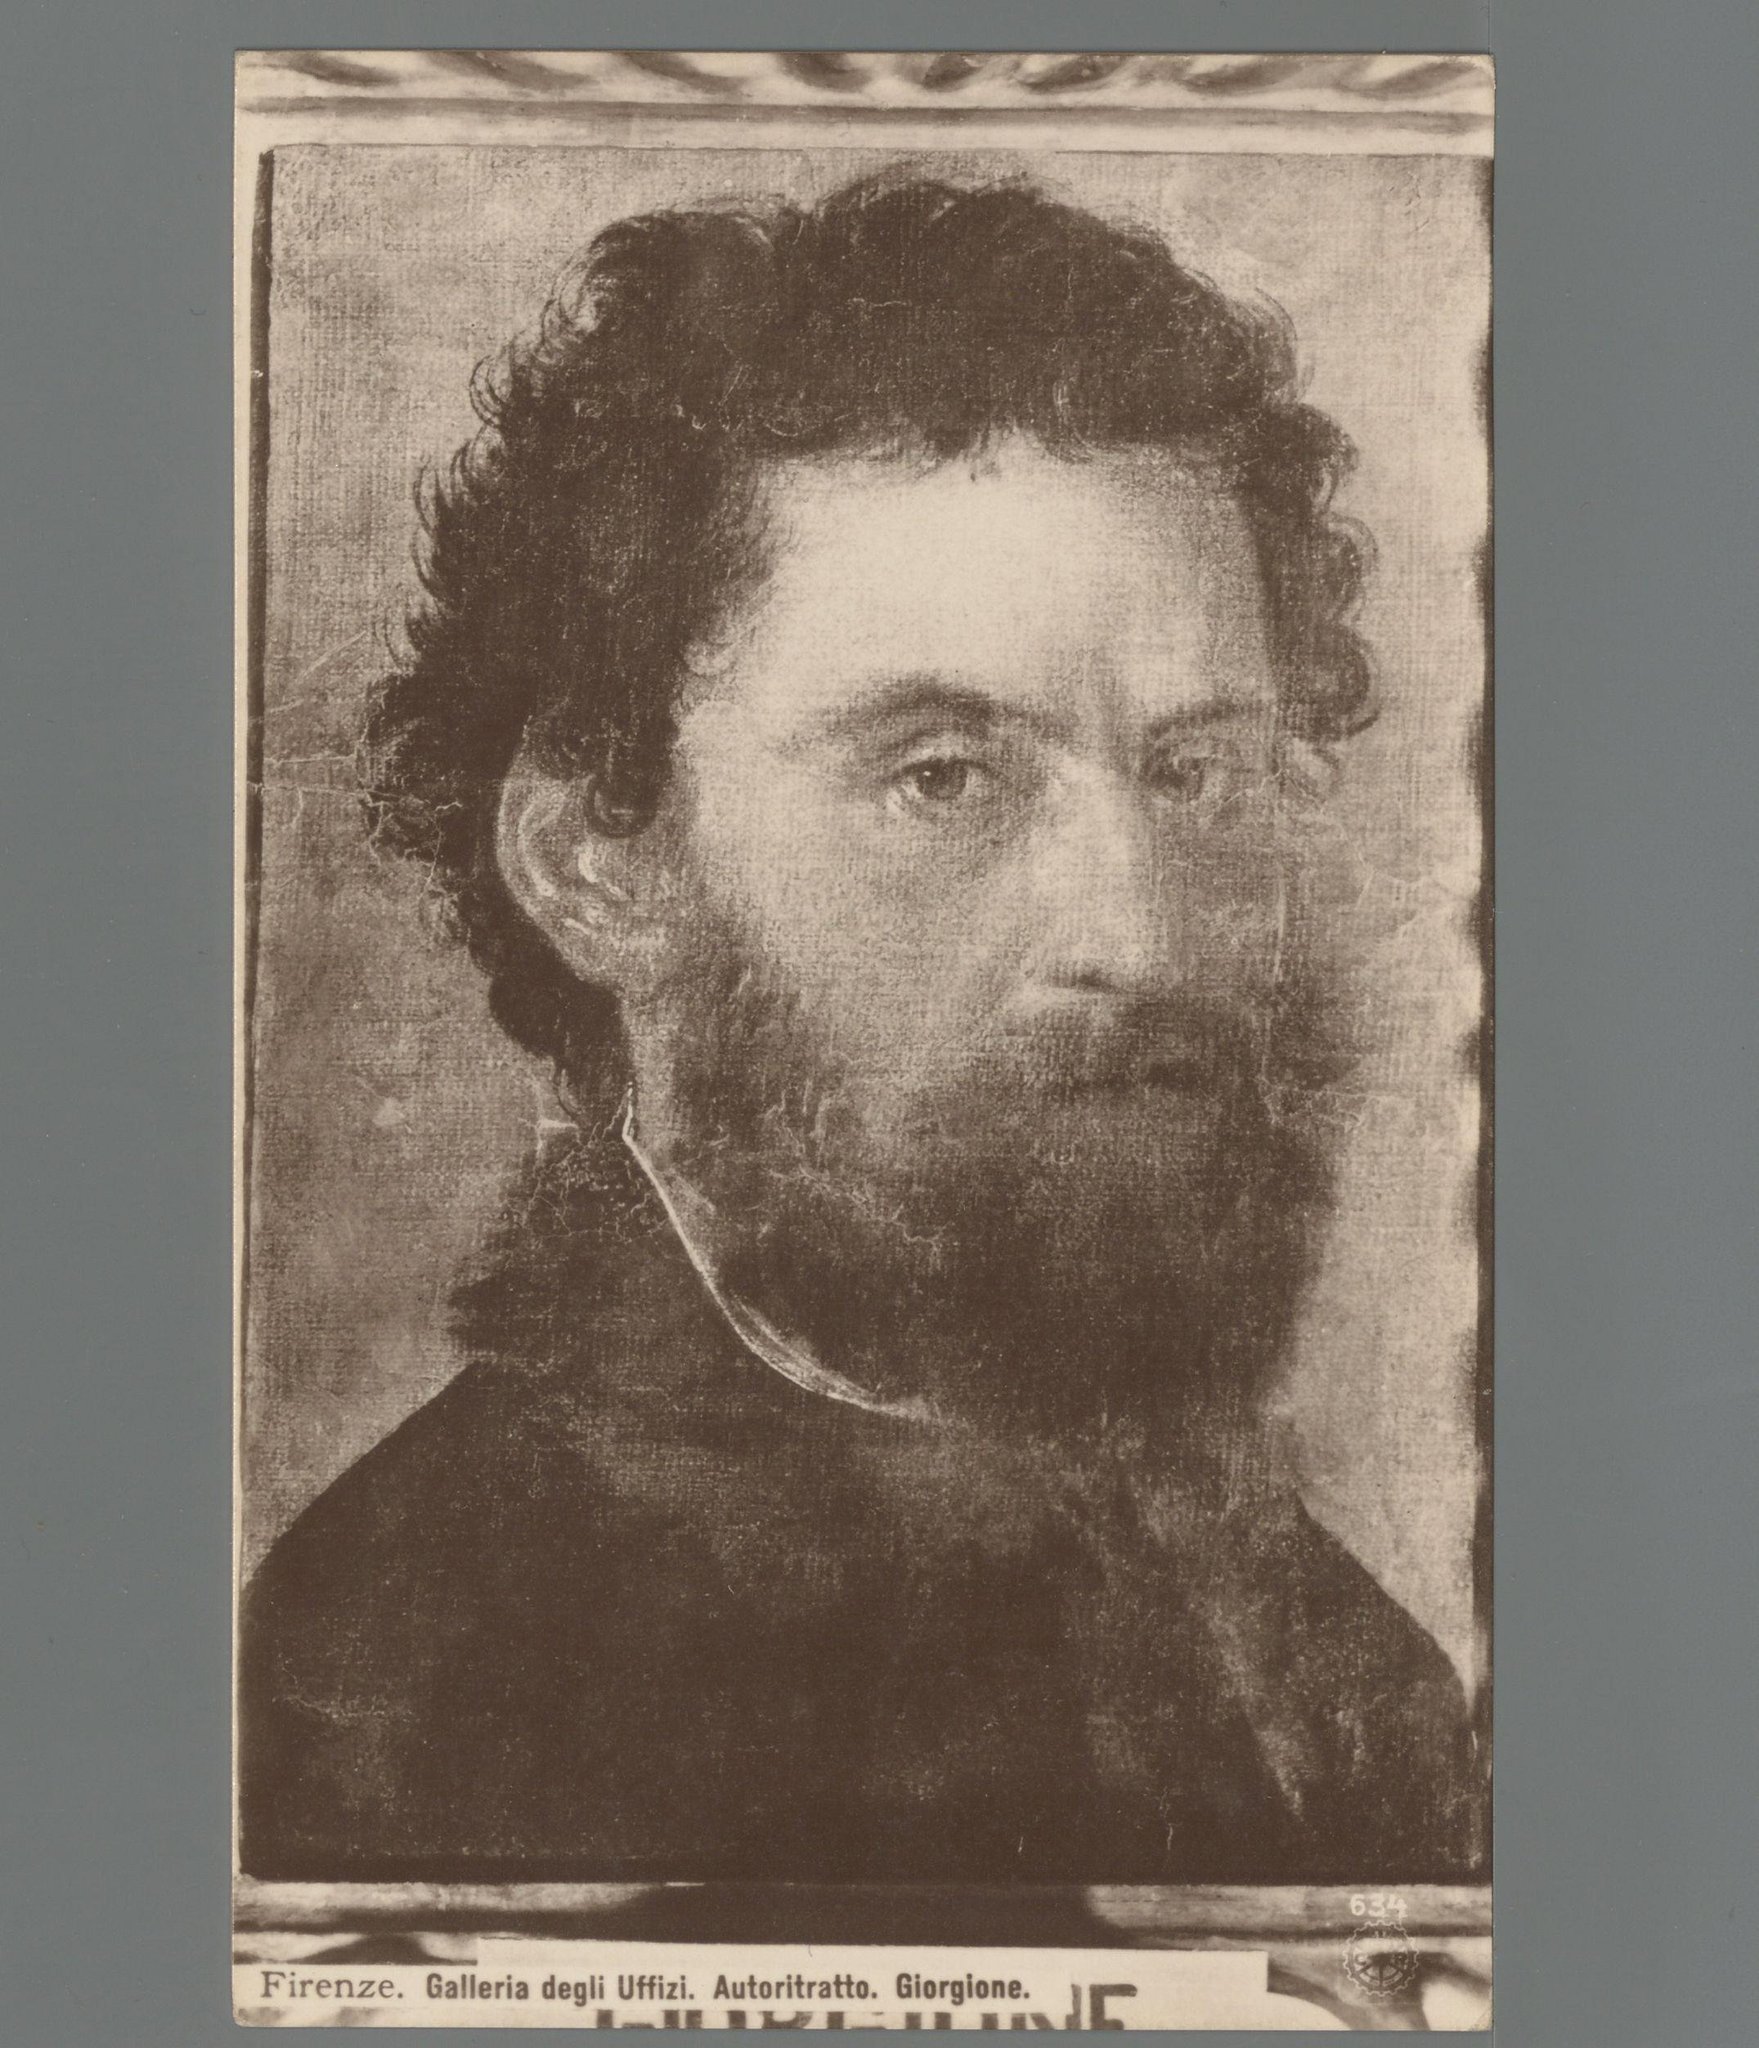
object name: reproduction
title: Firenze. Galleria degli Uffizi. Autoritratto. Giorgione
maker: giorgione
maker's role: painter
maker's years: 1478-1510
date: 1906-1930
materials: photographic support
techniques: photography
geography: italy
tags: painter, giorgione, portrait, self-portrait of artist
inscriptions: collector's mark: ‘AFE v S’